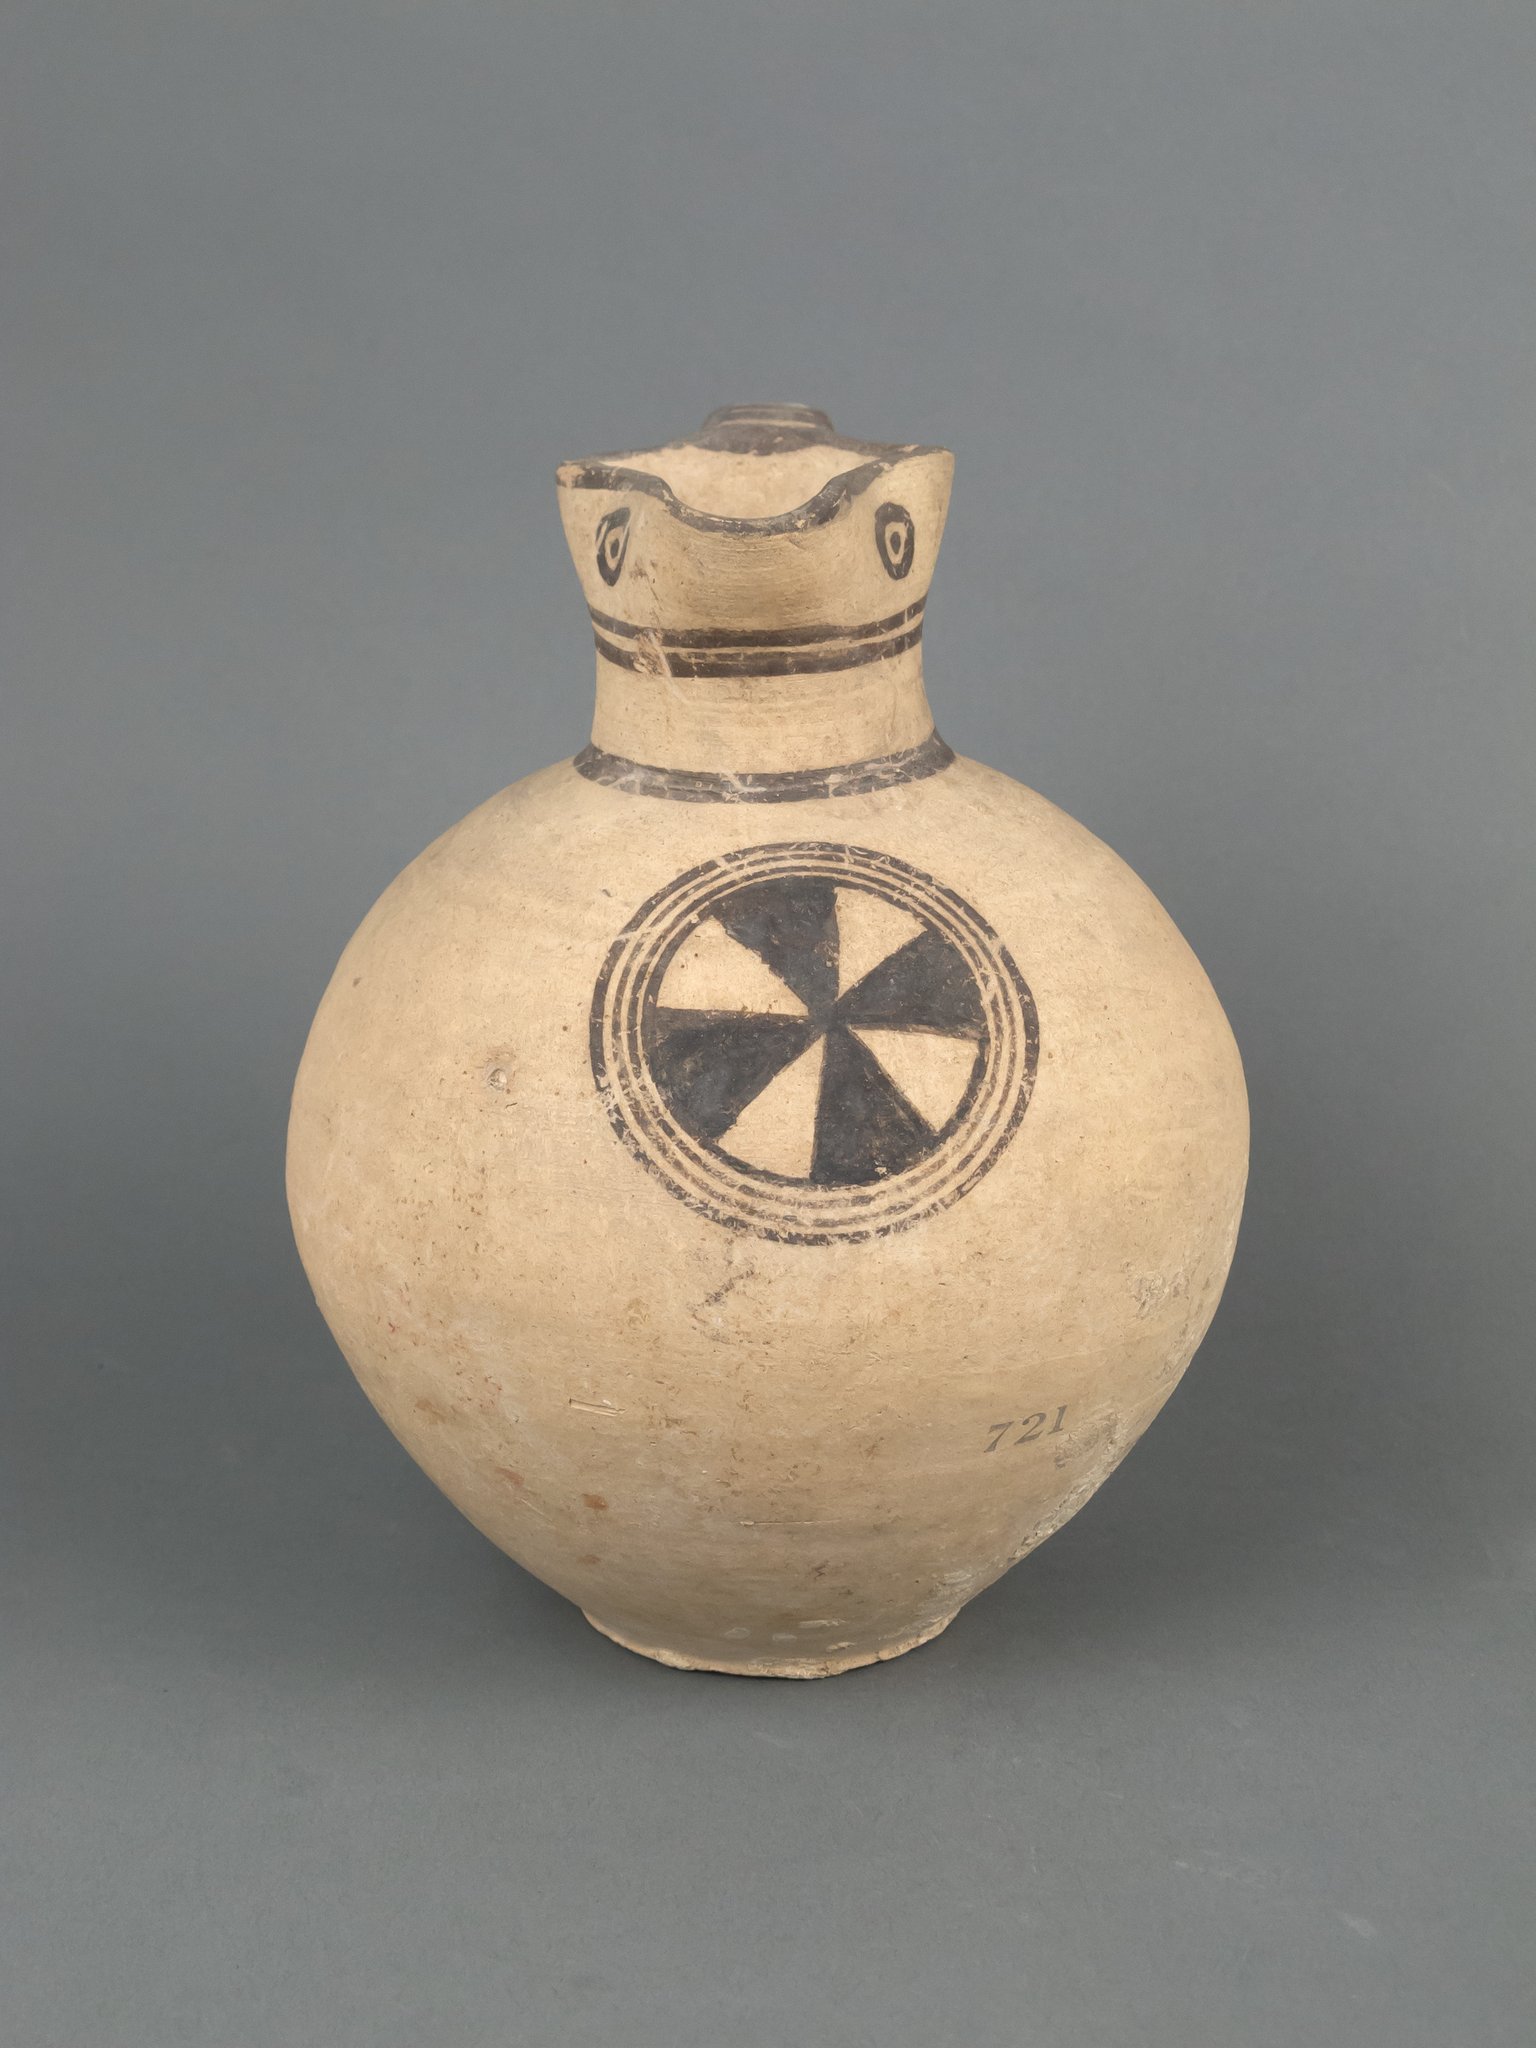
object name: oinochoe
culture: cypriot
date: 1125-1050 BCE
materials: terracotta